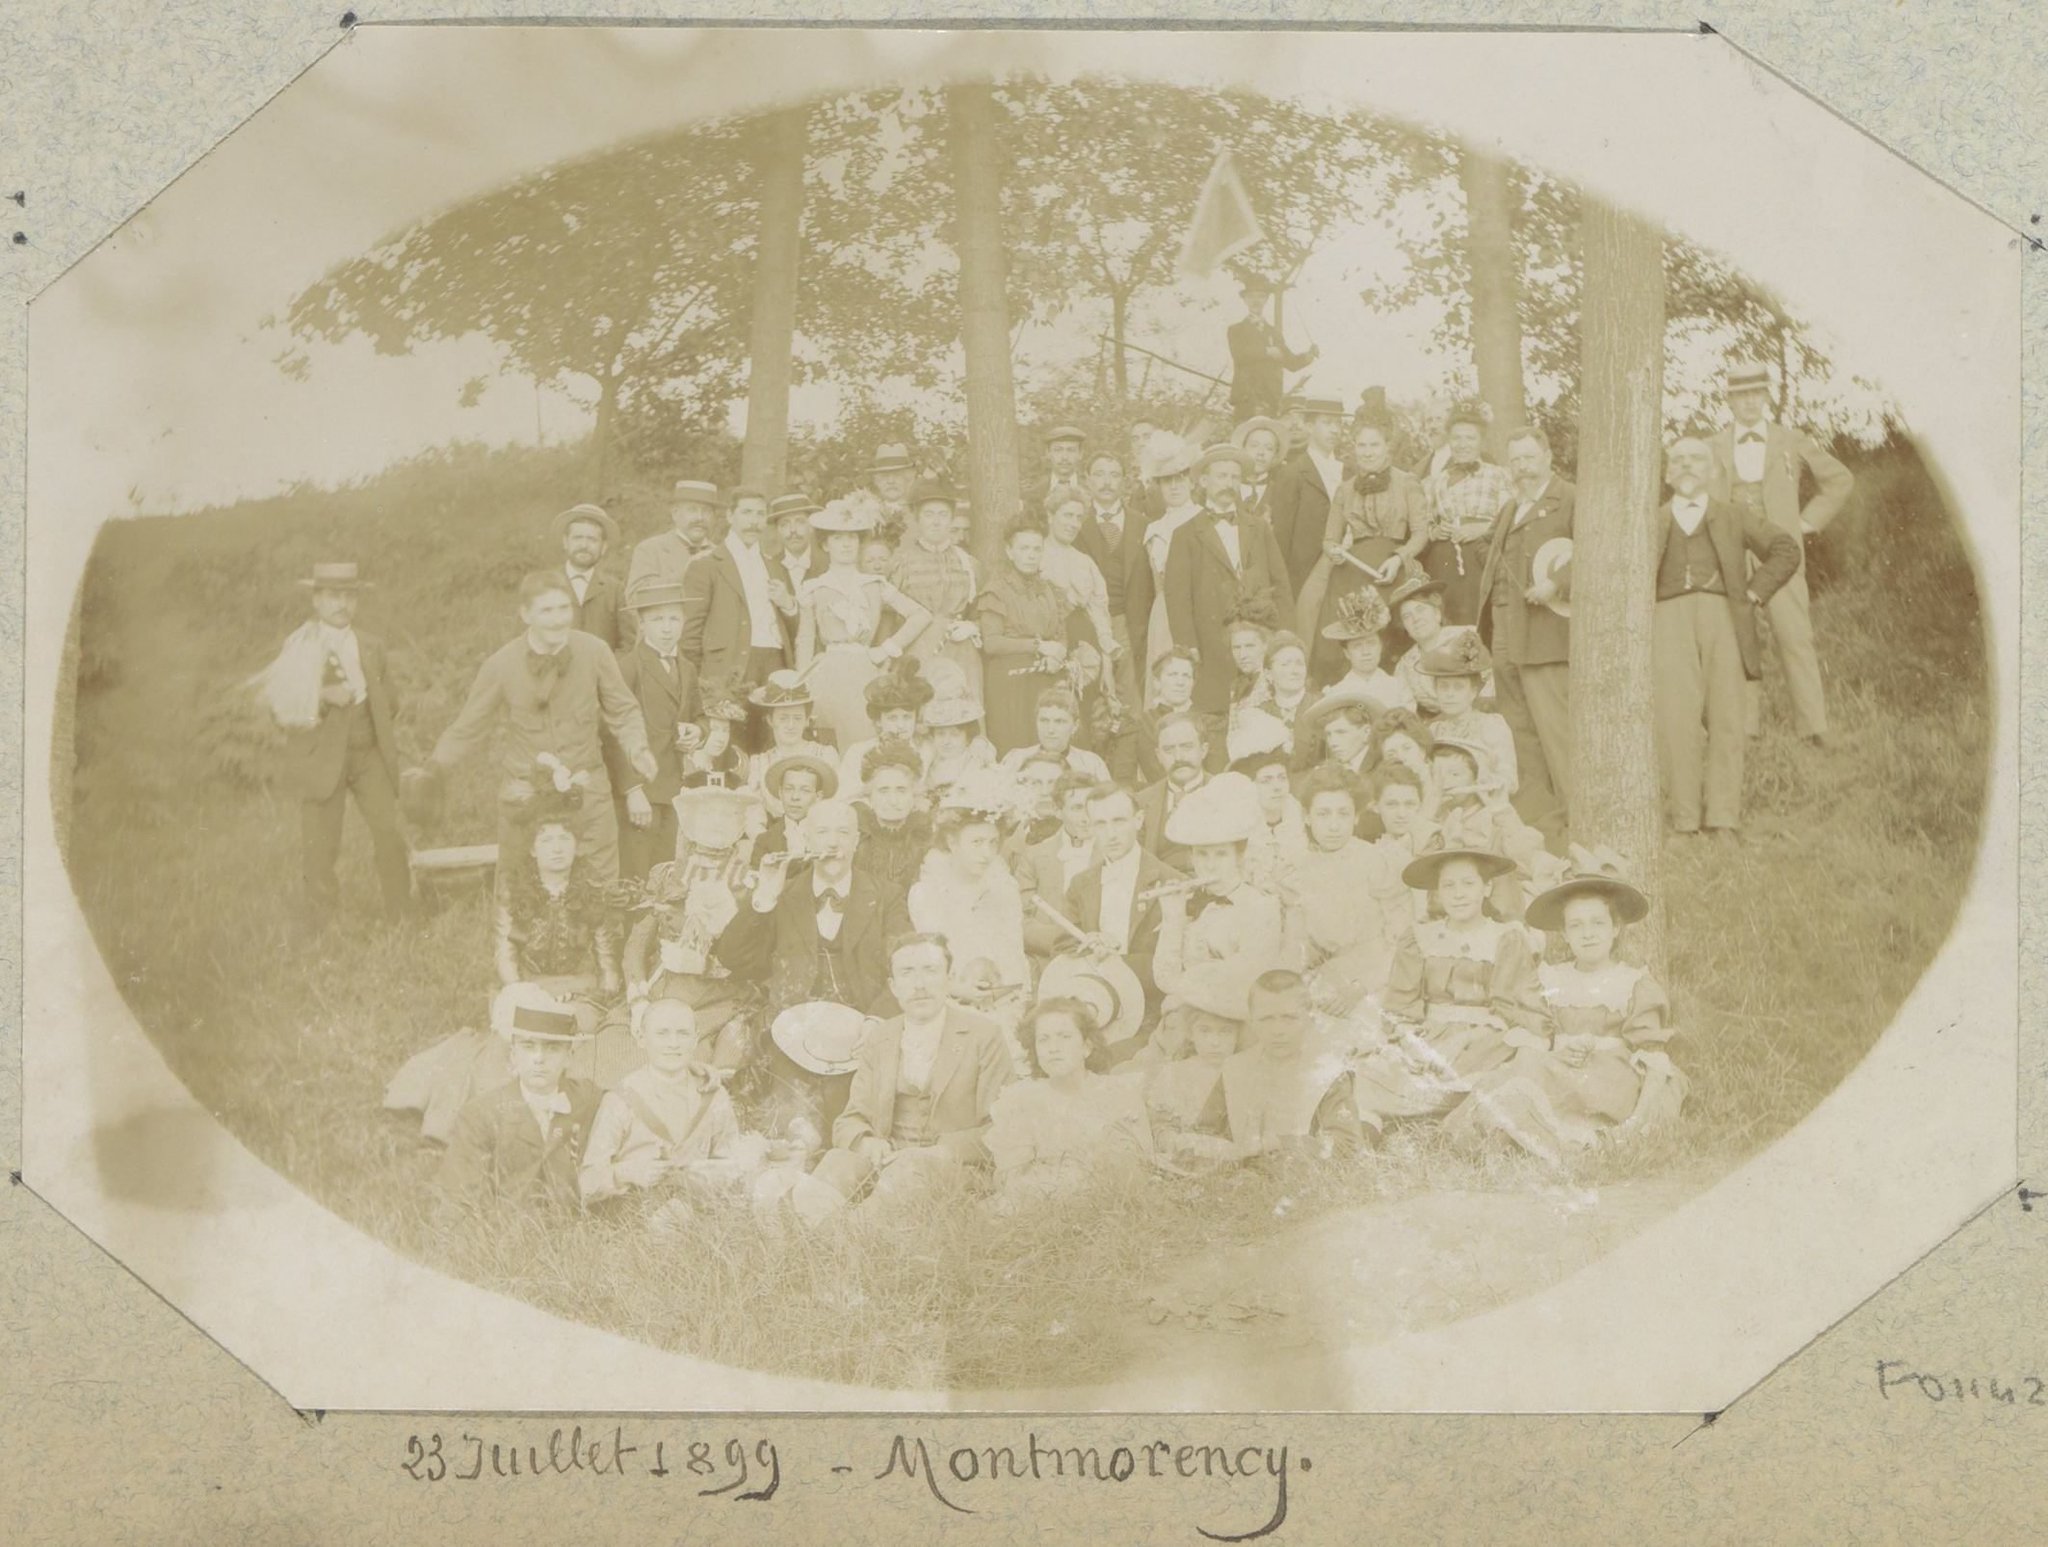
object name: photograph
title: Groepsportret van deelnemers aan een wandeling naar Montmorency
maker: Anonymous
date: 1899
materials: paper, photographic support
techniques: daylight paper print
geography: montmorency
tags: walking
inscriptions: inscription: ‘souvenir dela promenade du 23 juillet 1899 à Montmorency [...]’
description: Onderdeel van Album van een Franse amateur met foto's van Frankrijk, Algerije, Palmyra, de Wereldtentoonstelling van 1900 en van bekende Fransen.